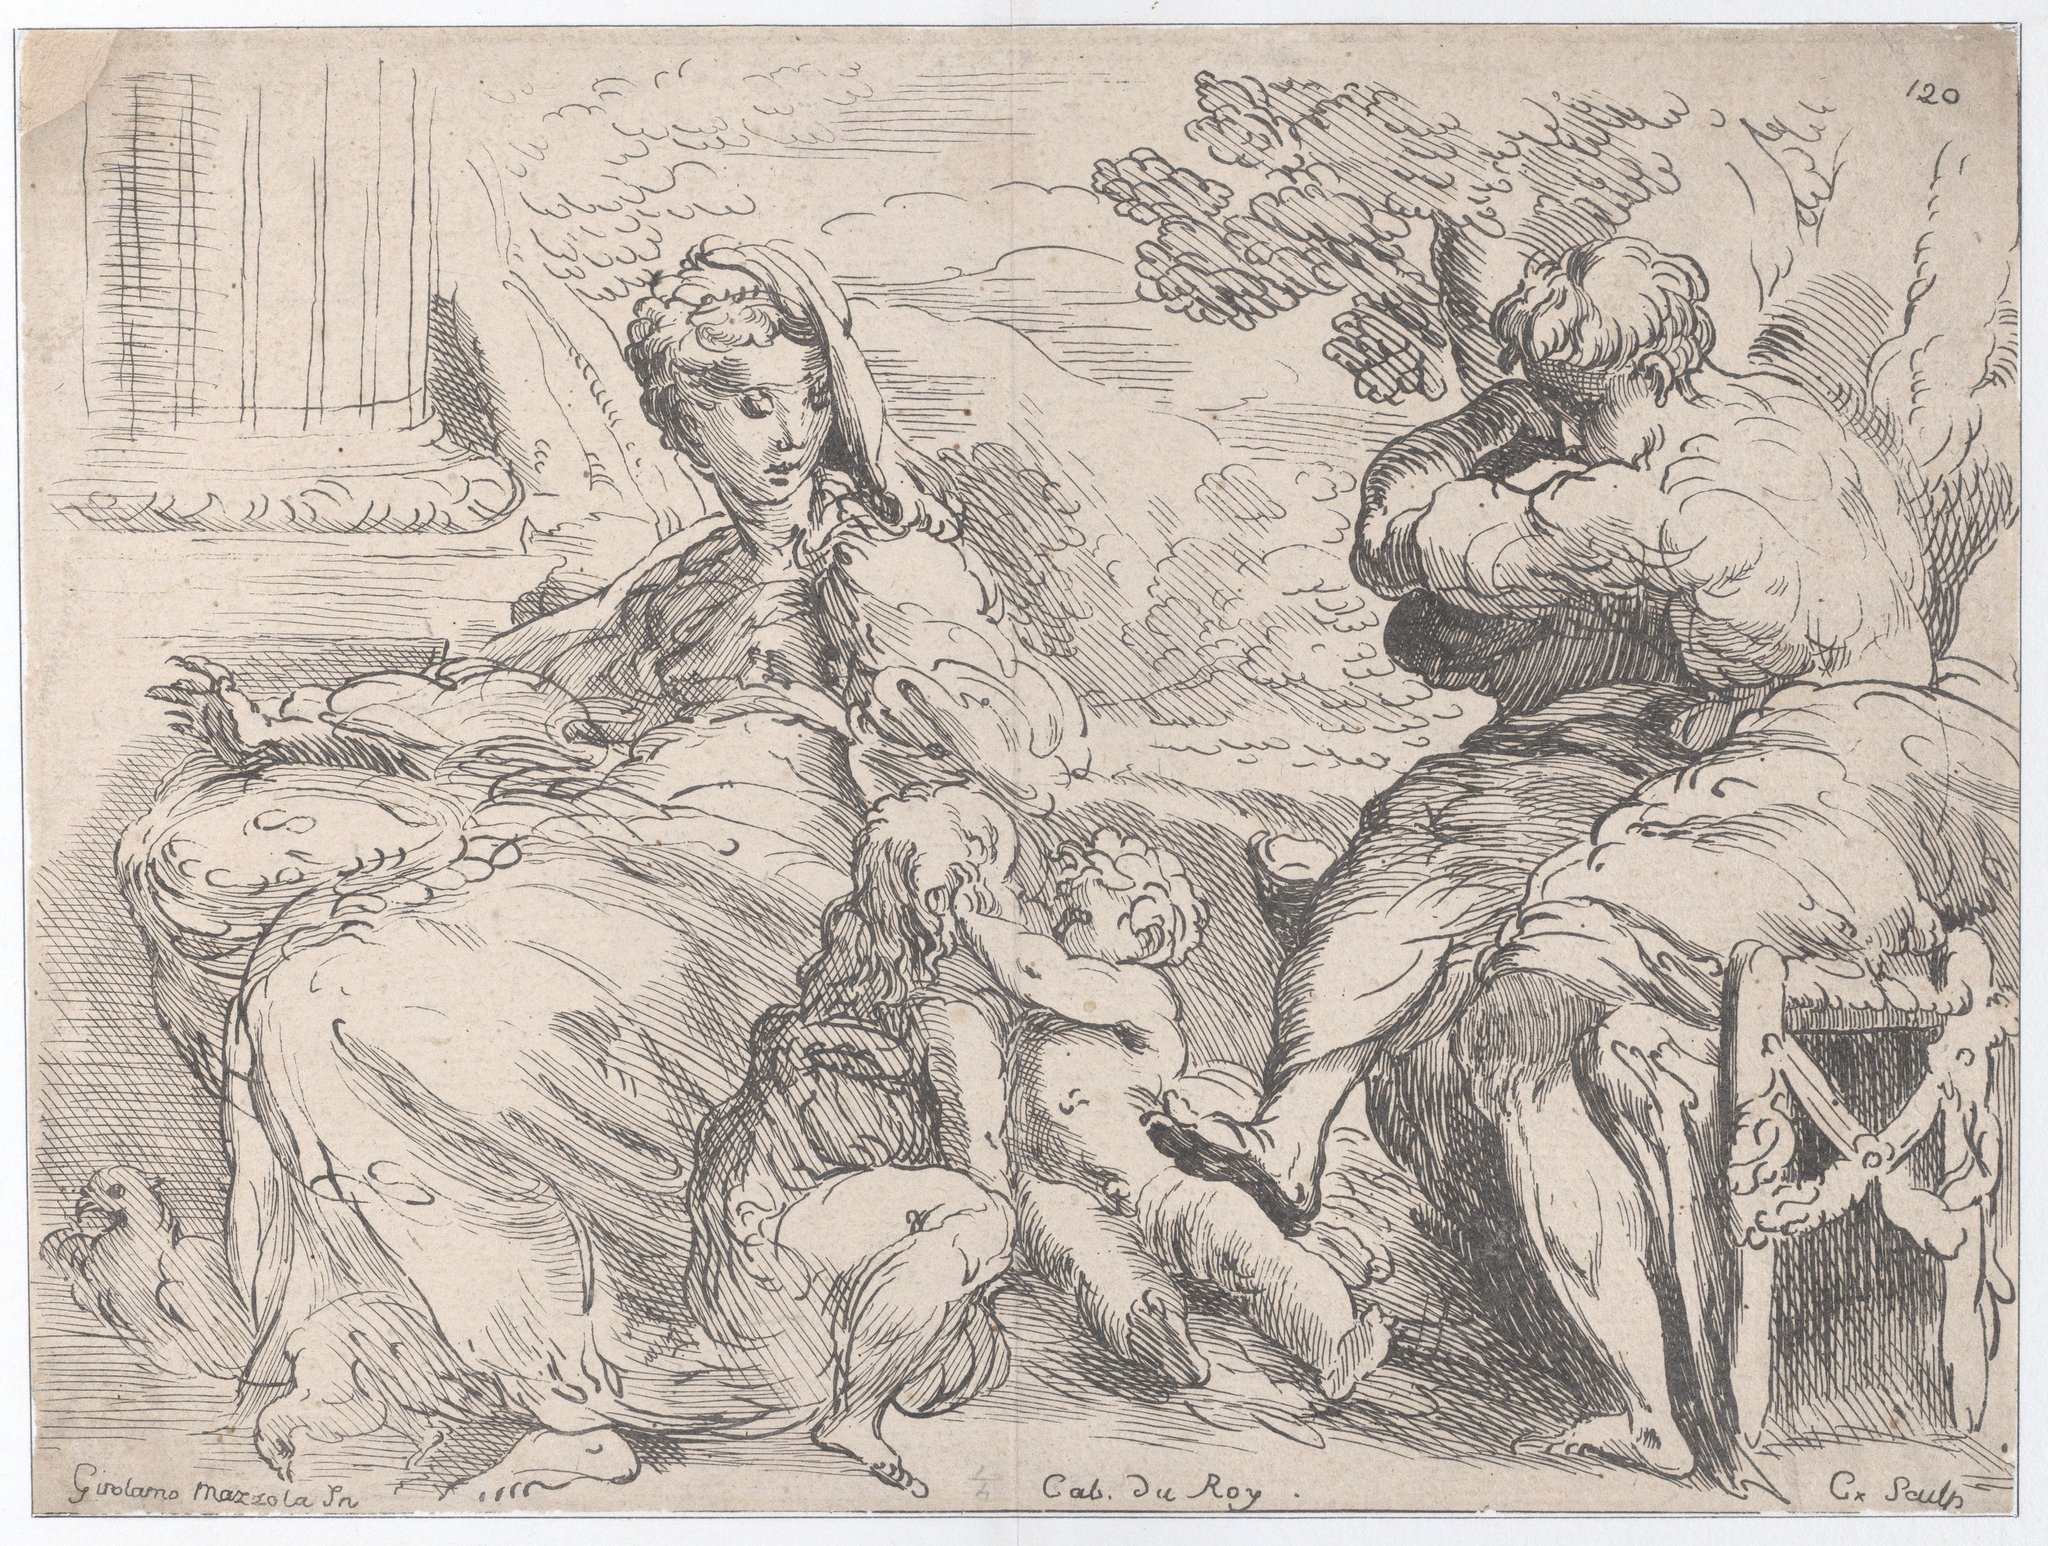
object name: print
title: Holy Family with St. John the Baptist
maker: anne claude philippe de tubières, comte de caylus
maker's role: artist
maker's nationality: french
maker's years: 1692-1765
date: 1701-1800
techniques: etching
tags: holy family,saint john the baptist